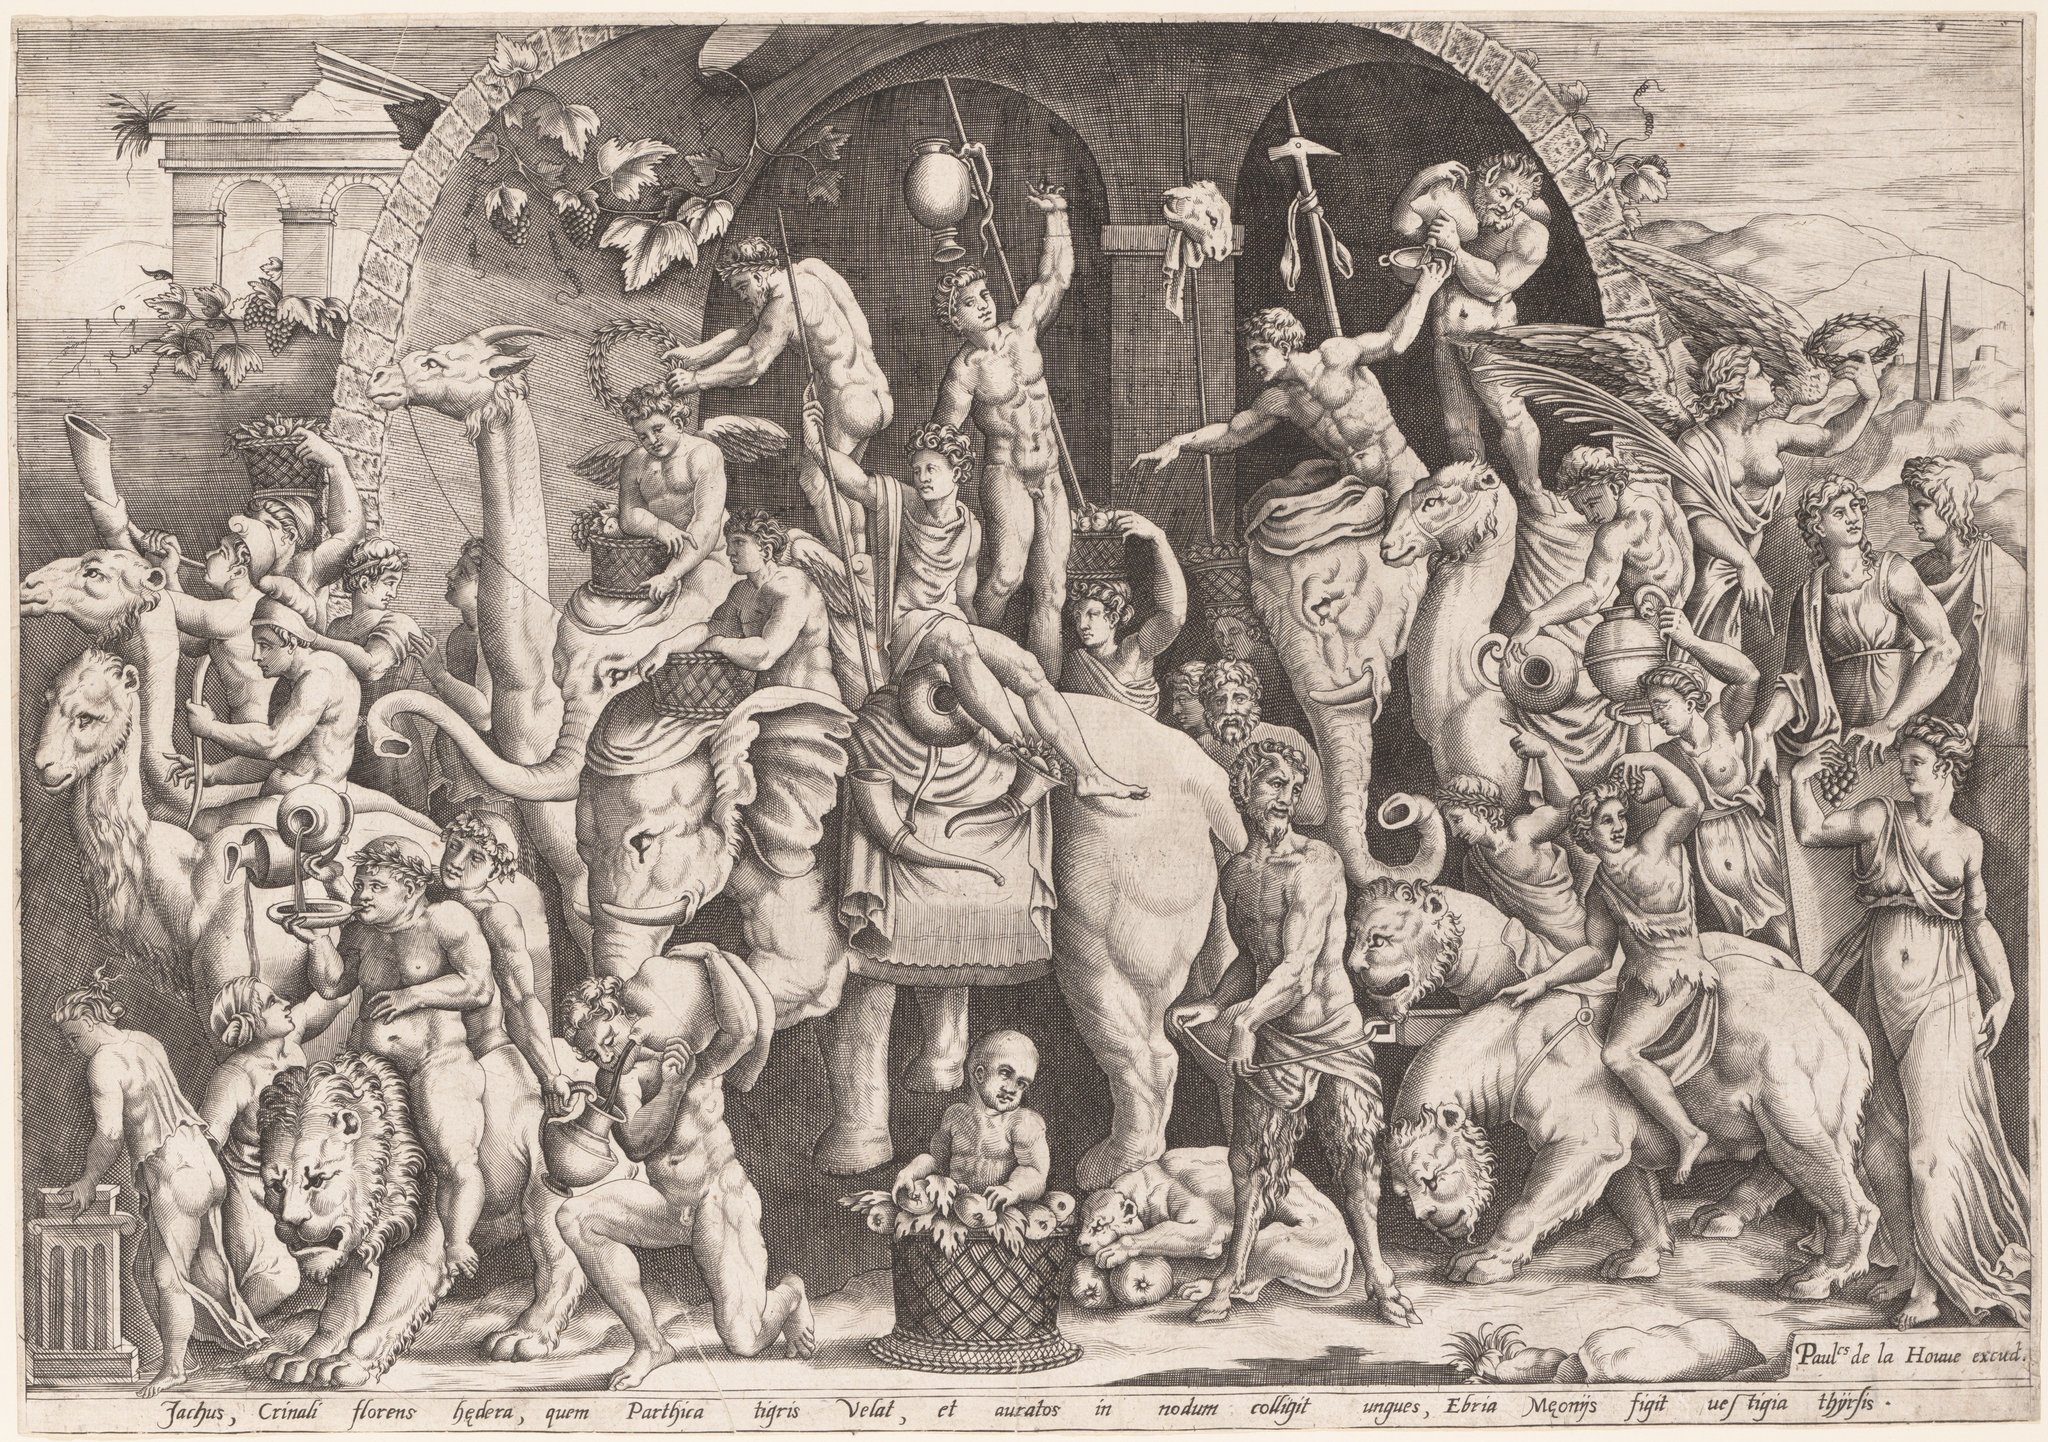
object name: print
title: The Indian Triumph of Bacchus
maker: anonymous, french, 16th century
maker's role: artist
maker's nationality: french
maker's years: 1500-1600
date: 1534-1566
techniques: engraving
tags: men,bacchus,camels,elephants,lions